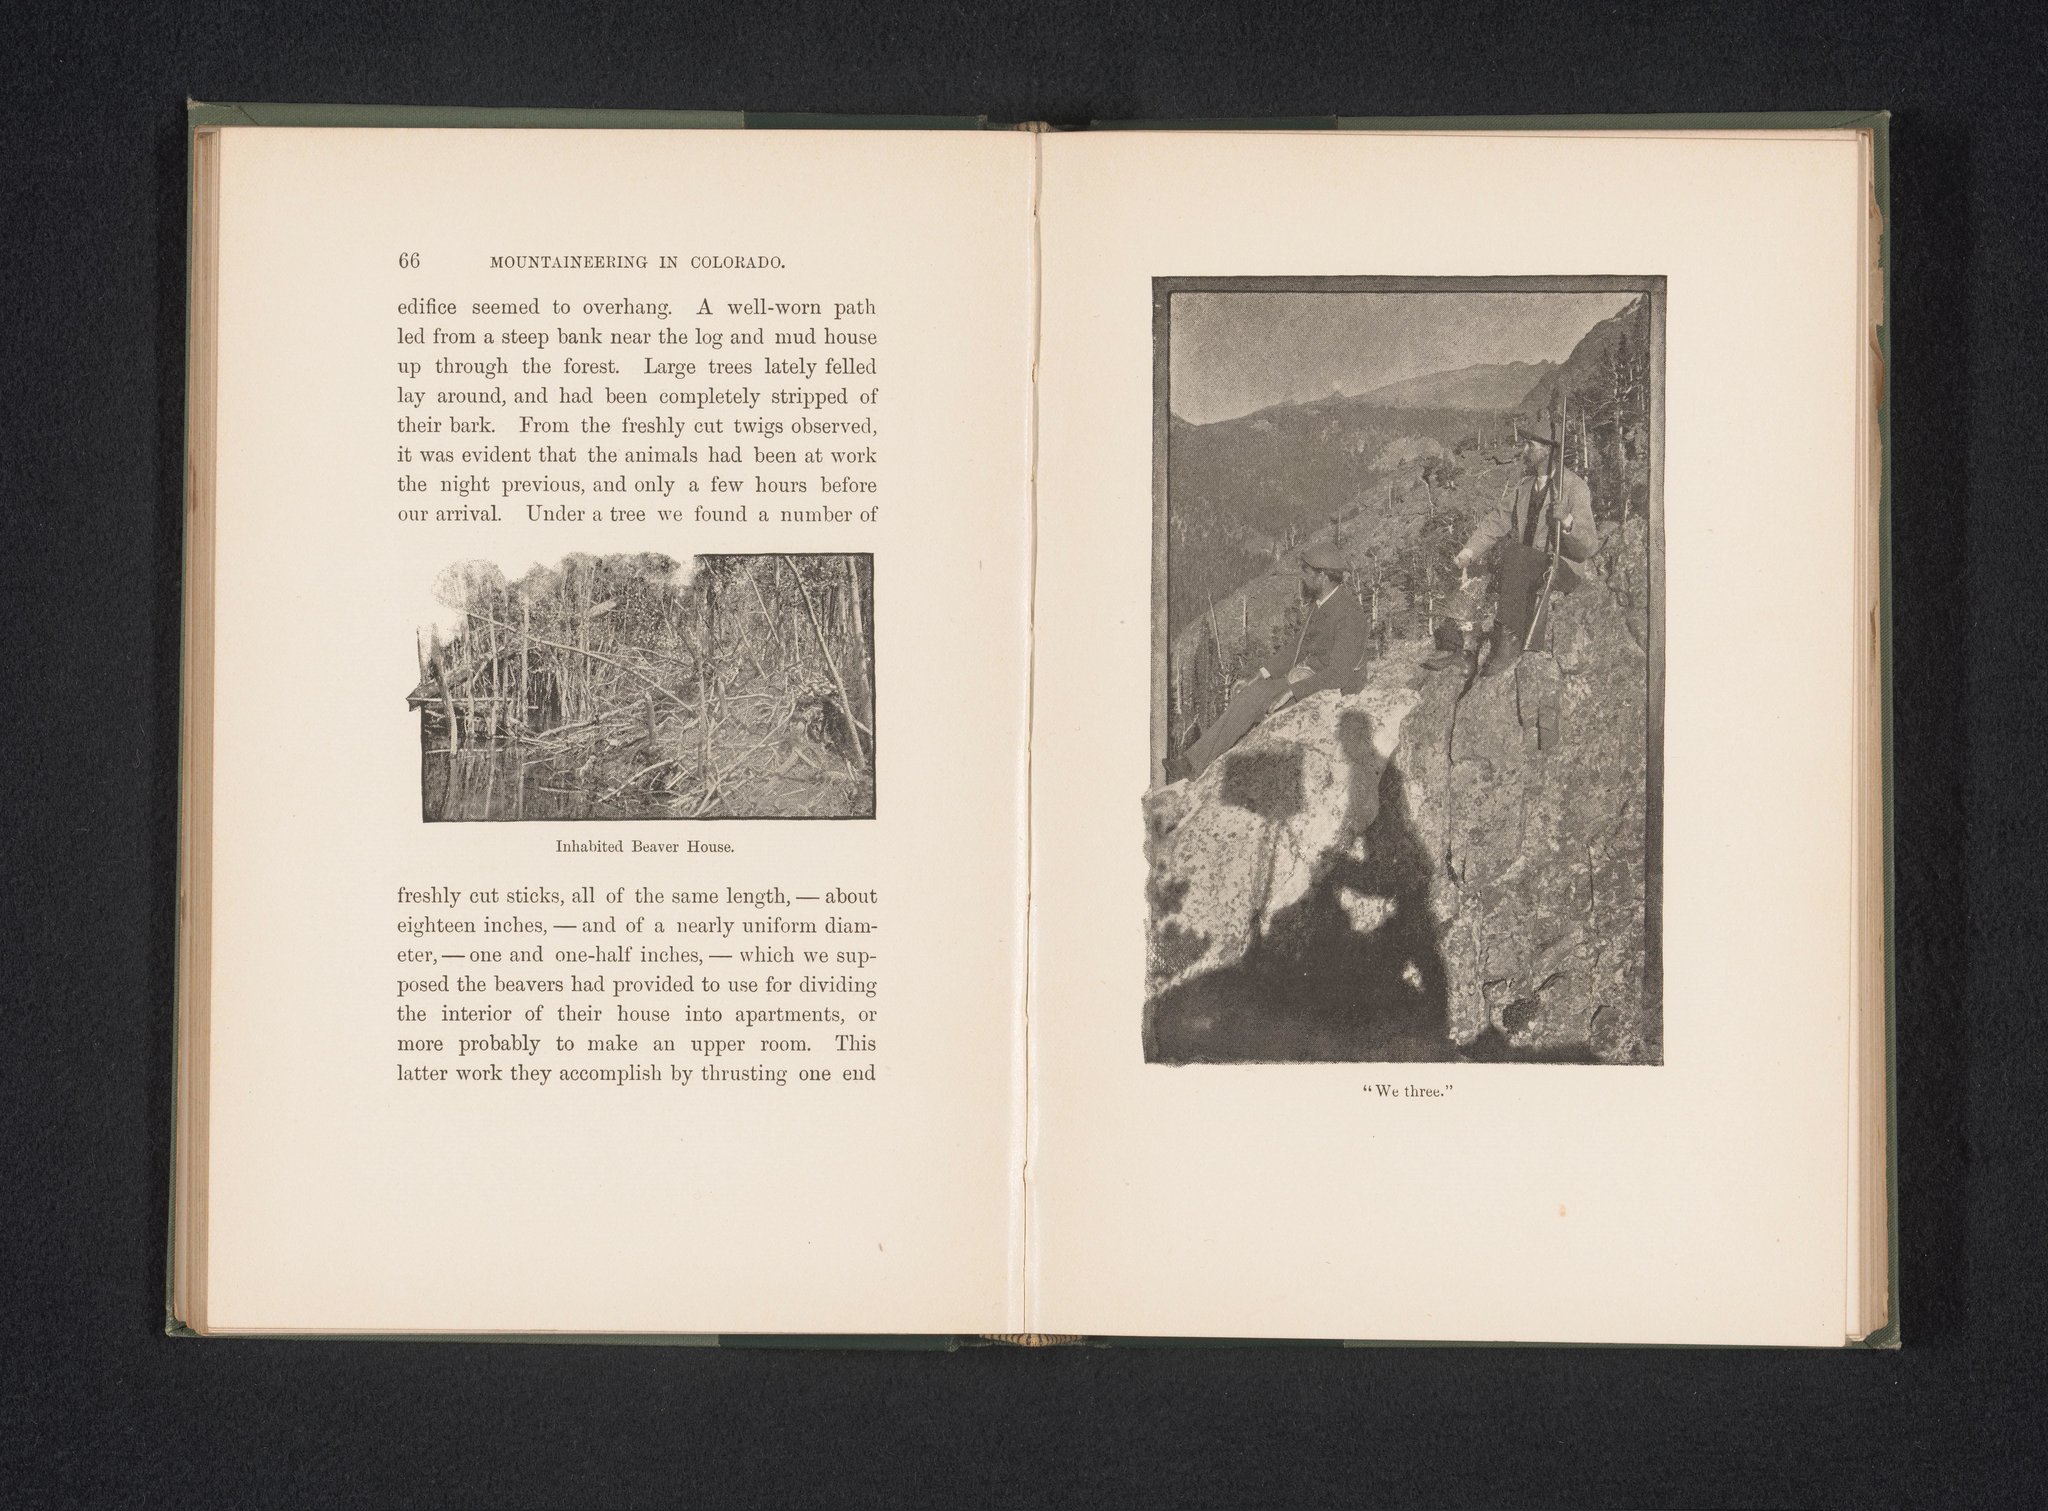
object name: photomechanical print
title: Gezicht op twee mannen in de bergen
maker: frederick hastings chapin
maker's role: antropoloog, archeoloog, fotograaf, schrijver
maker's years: 1852-1900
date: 1885-1890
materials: paper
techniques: autotype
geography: boston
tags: mountain climbing, mountaineering, wildlife reserve, national park, mountains